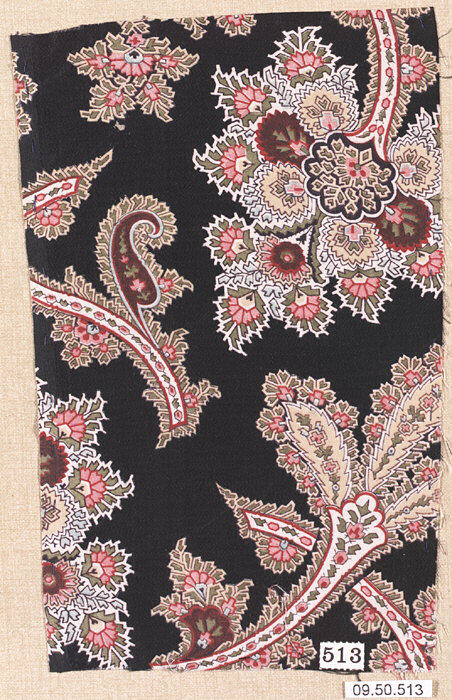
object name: piece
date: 1801-1900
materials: cotton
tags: leaves